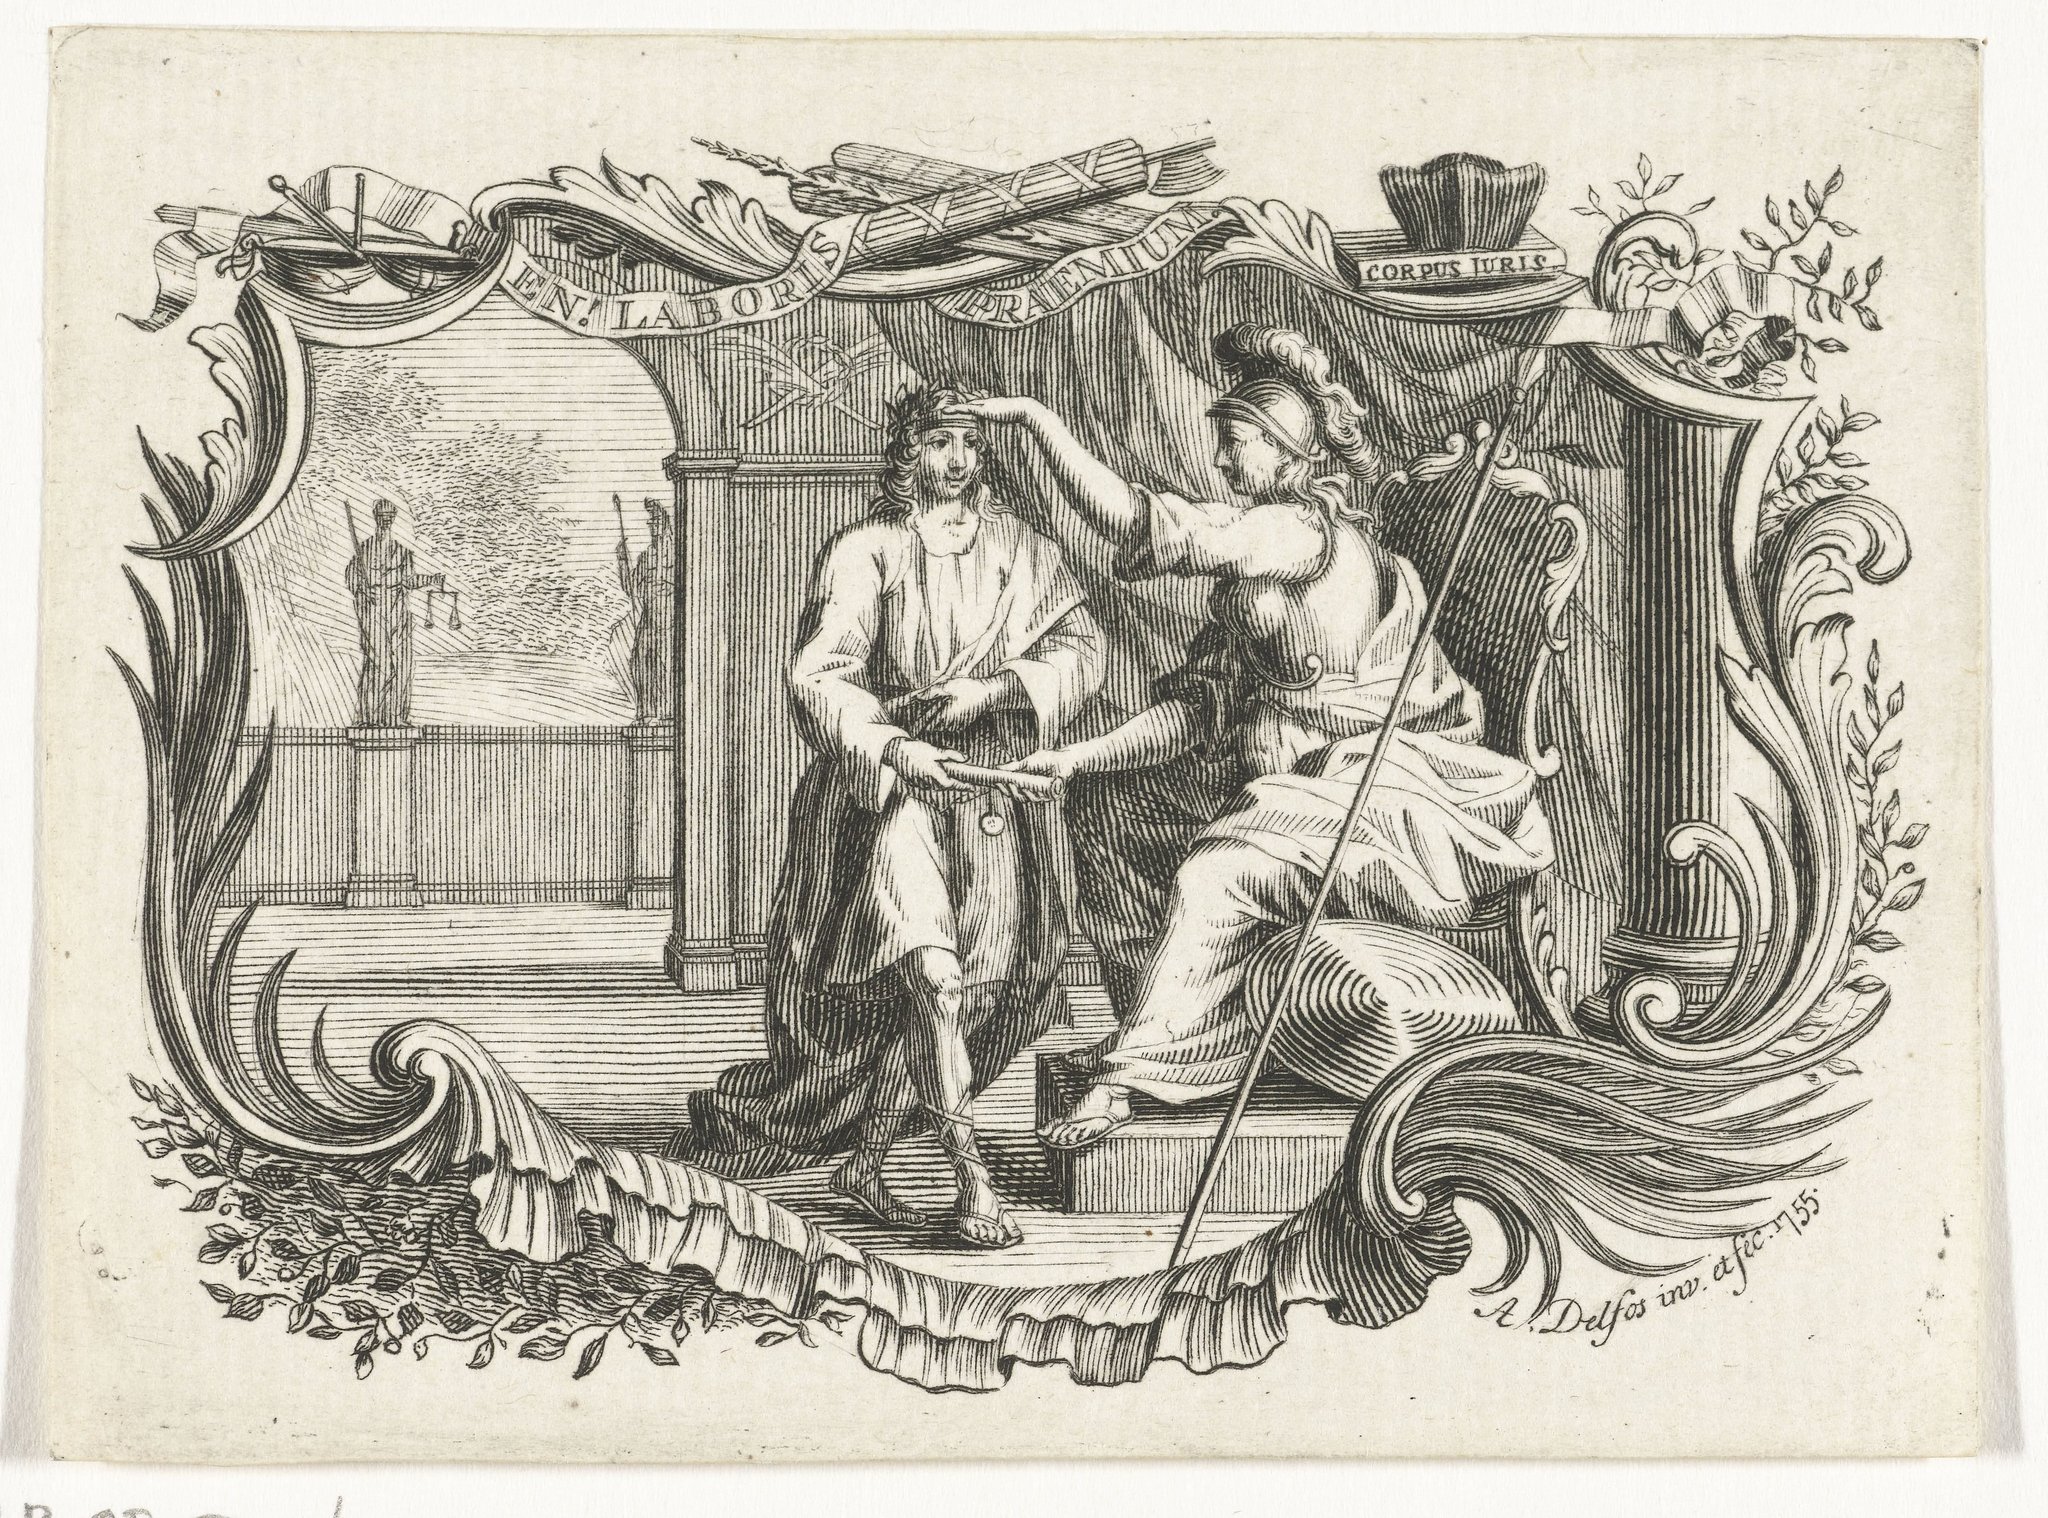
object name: print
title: Minerva beloont of huldigt man voor zijn werk, in cartouche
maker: abraham delfos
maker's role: draughtsman, painter, print maker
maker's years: 1731-1820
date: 1755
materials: paper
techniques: etching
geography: leiden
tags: (story of) minerva (pallas, athena)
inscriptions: collector's mark: Lugt 240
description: Minerva zittend op troon beloont of huldigt een man met lauwerkrans en document voor zijn werk, op achtergrond beeld van Justitia op balustrade, in cartouche met motto En! laboris praemium en doctorsmuts.